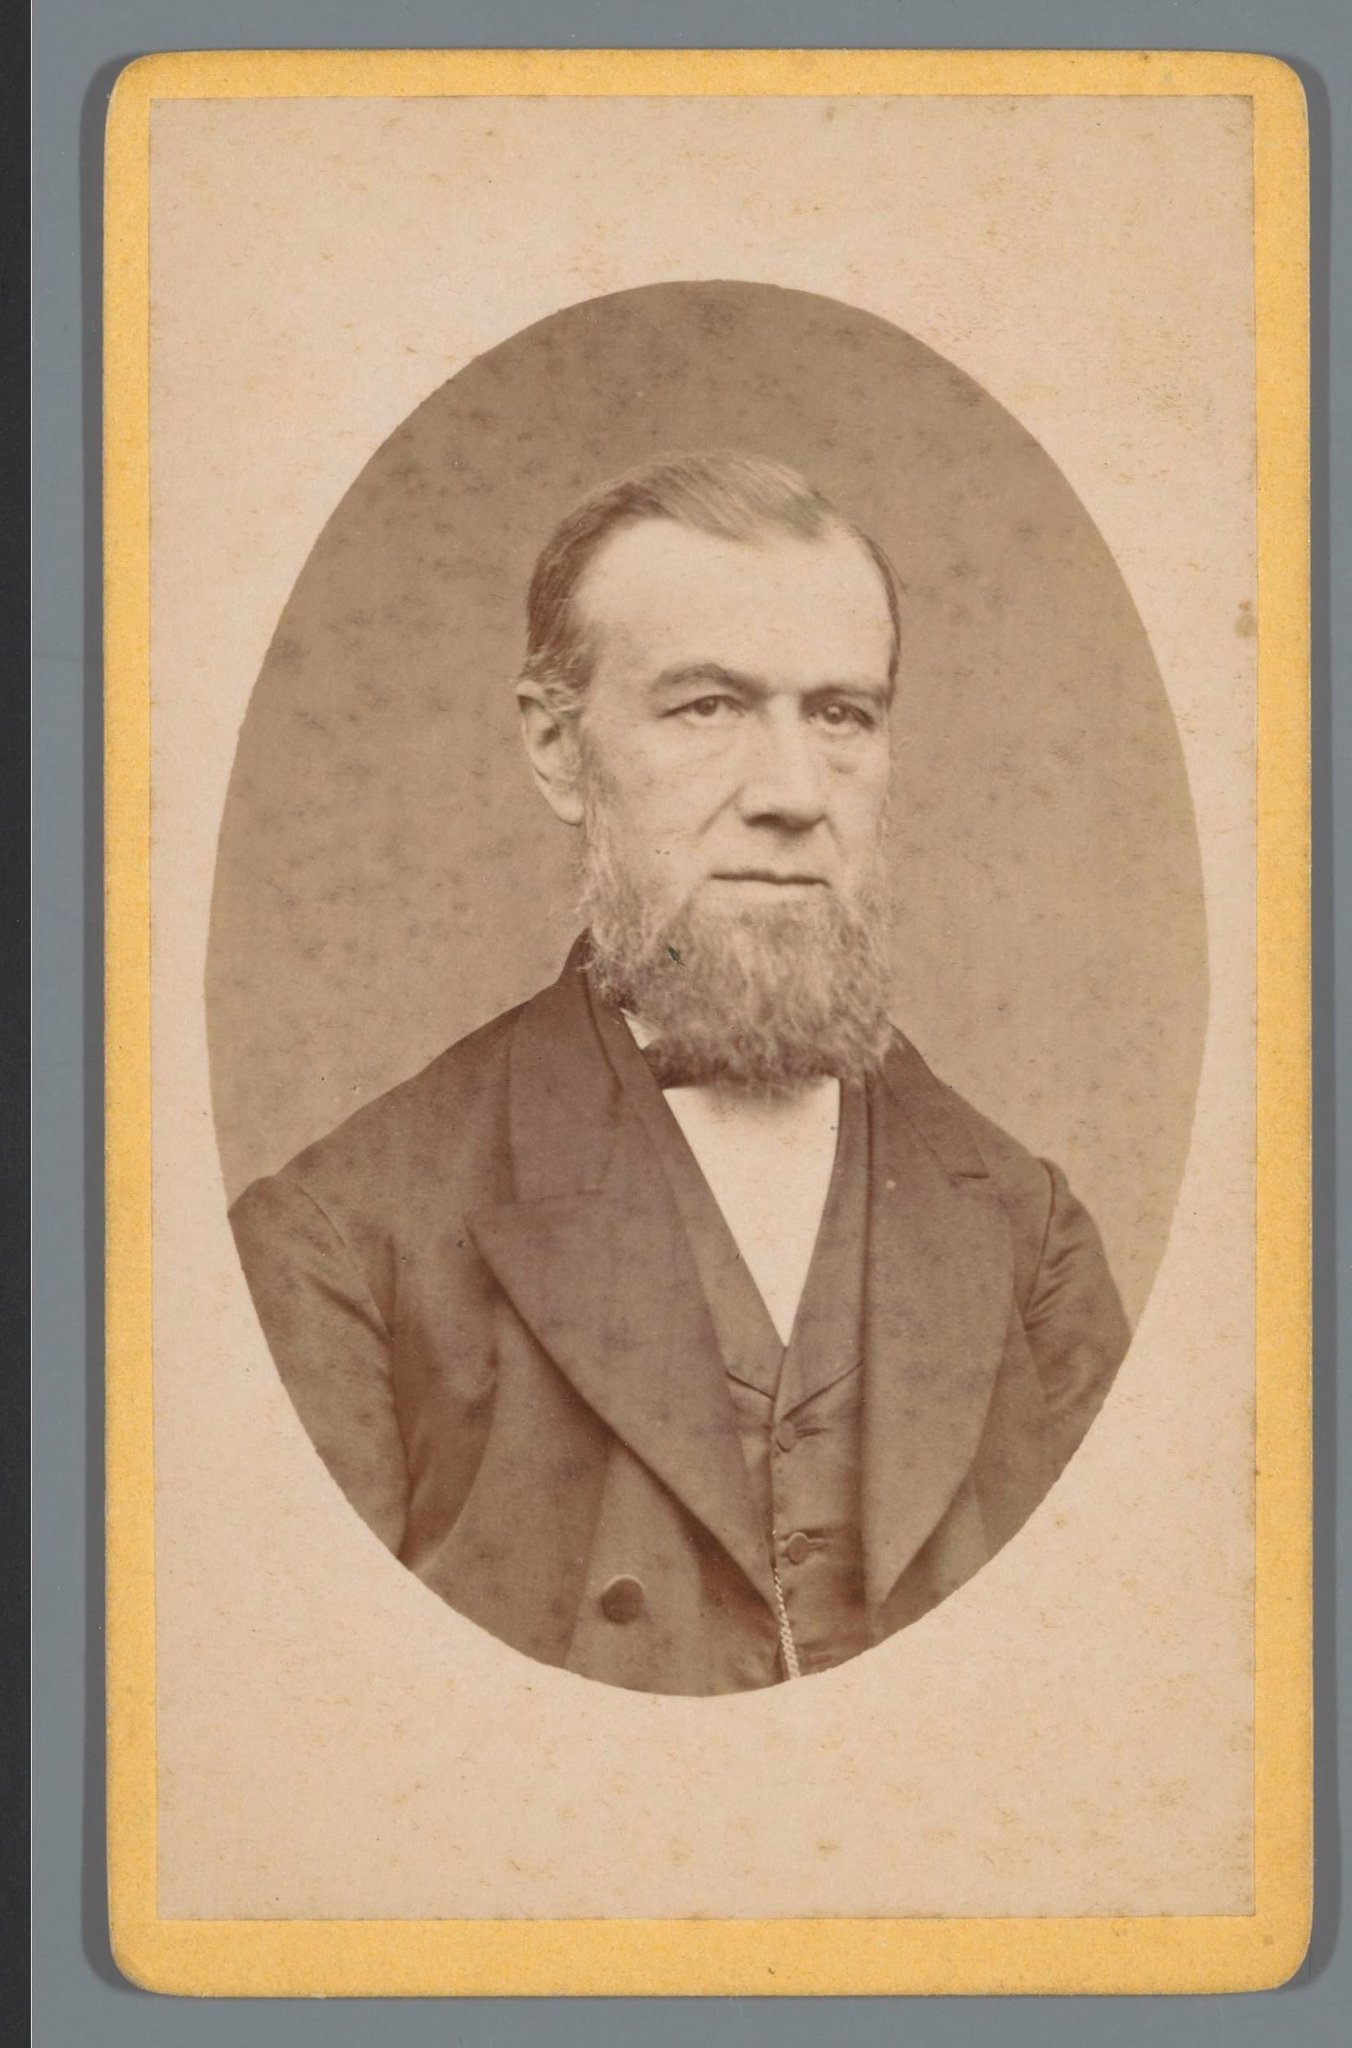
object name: carte de visite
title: Portret van een onbekende man met baard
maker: benjamin van der heide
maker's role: fotograaf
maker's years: 1837-1928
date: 1879-1882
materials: cardboard, paper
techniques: albumen print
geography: harlingen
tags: adult man, historical persons, beard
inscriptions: inscription: ‘Photographisch Atelier/ van/ B. VAN DER HEIDE/ te/ HARLINGEN./ Voor Nabestellingen blijven de Platen bewaard.’, inscription: ‘Grootpa van Hijhe’